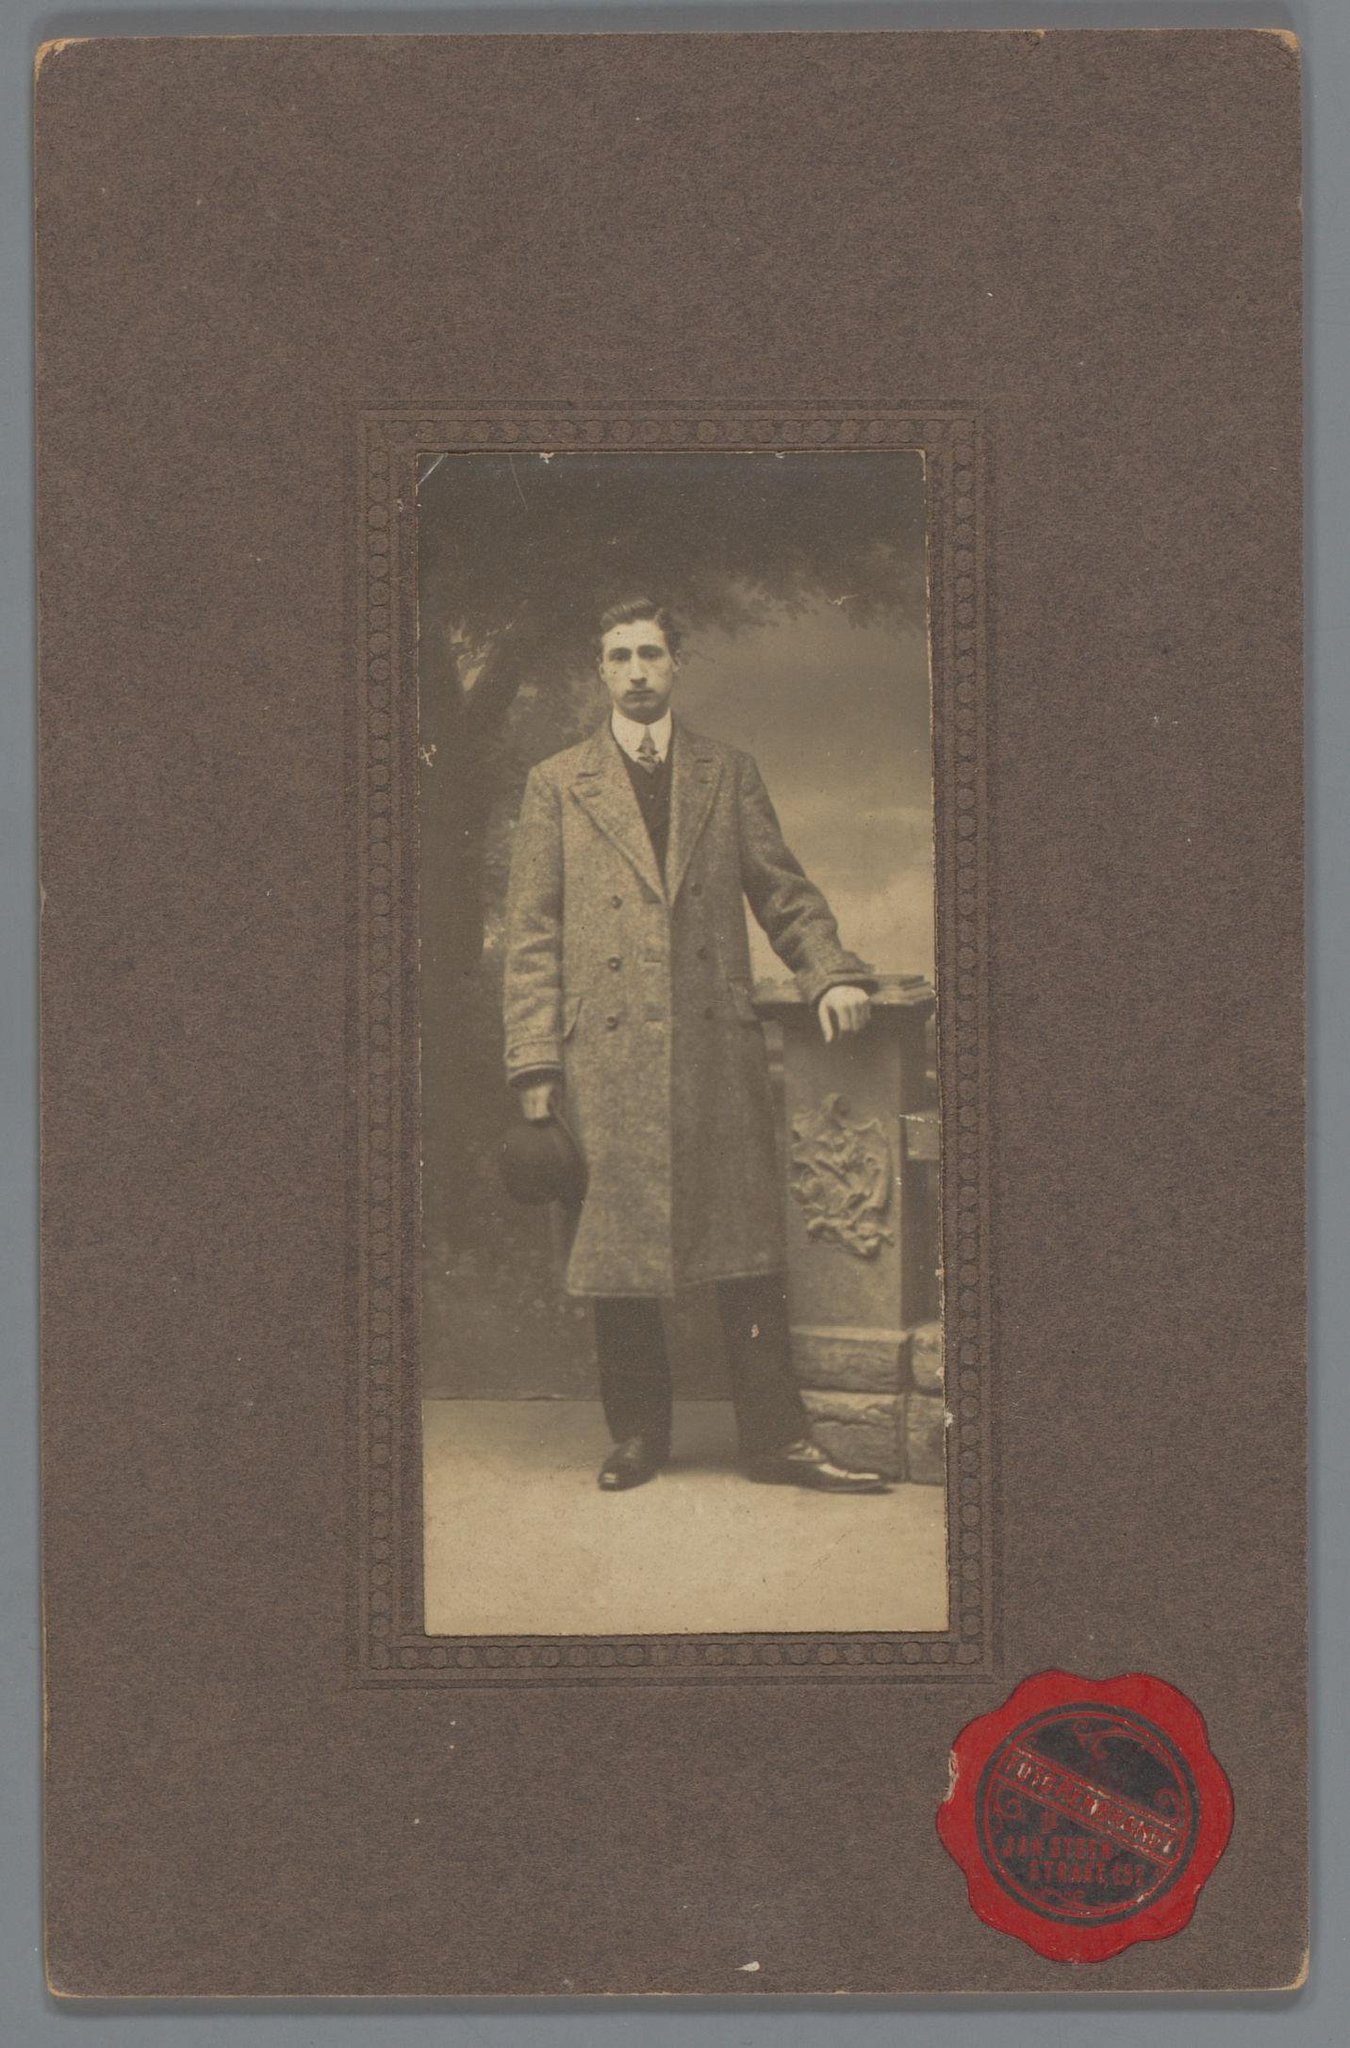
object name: photograph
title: Portret van een onbekende man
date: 1900-1920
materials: cardboard, photographic support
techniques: gelatin silver print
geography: amsterdam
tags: adult man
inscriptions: inscription: ‘Foto Rembrandt Jan Steenstraat 131’